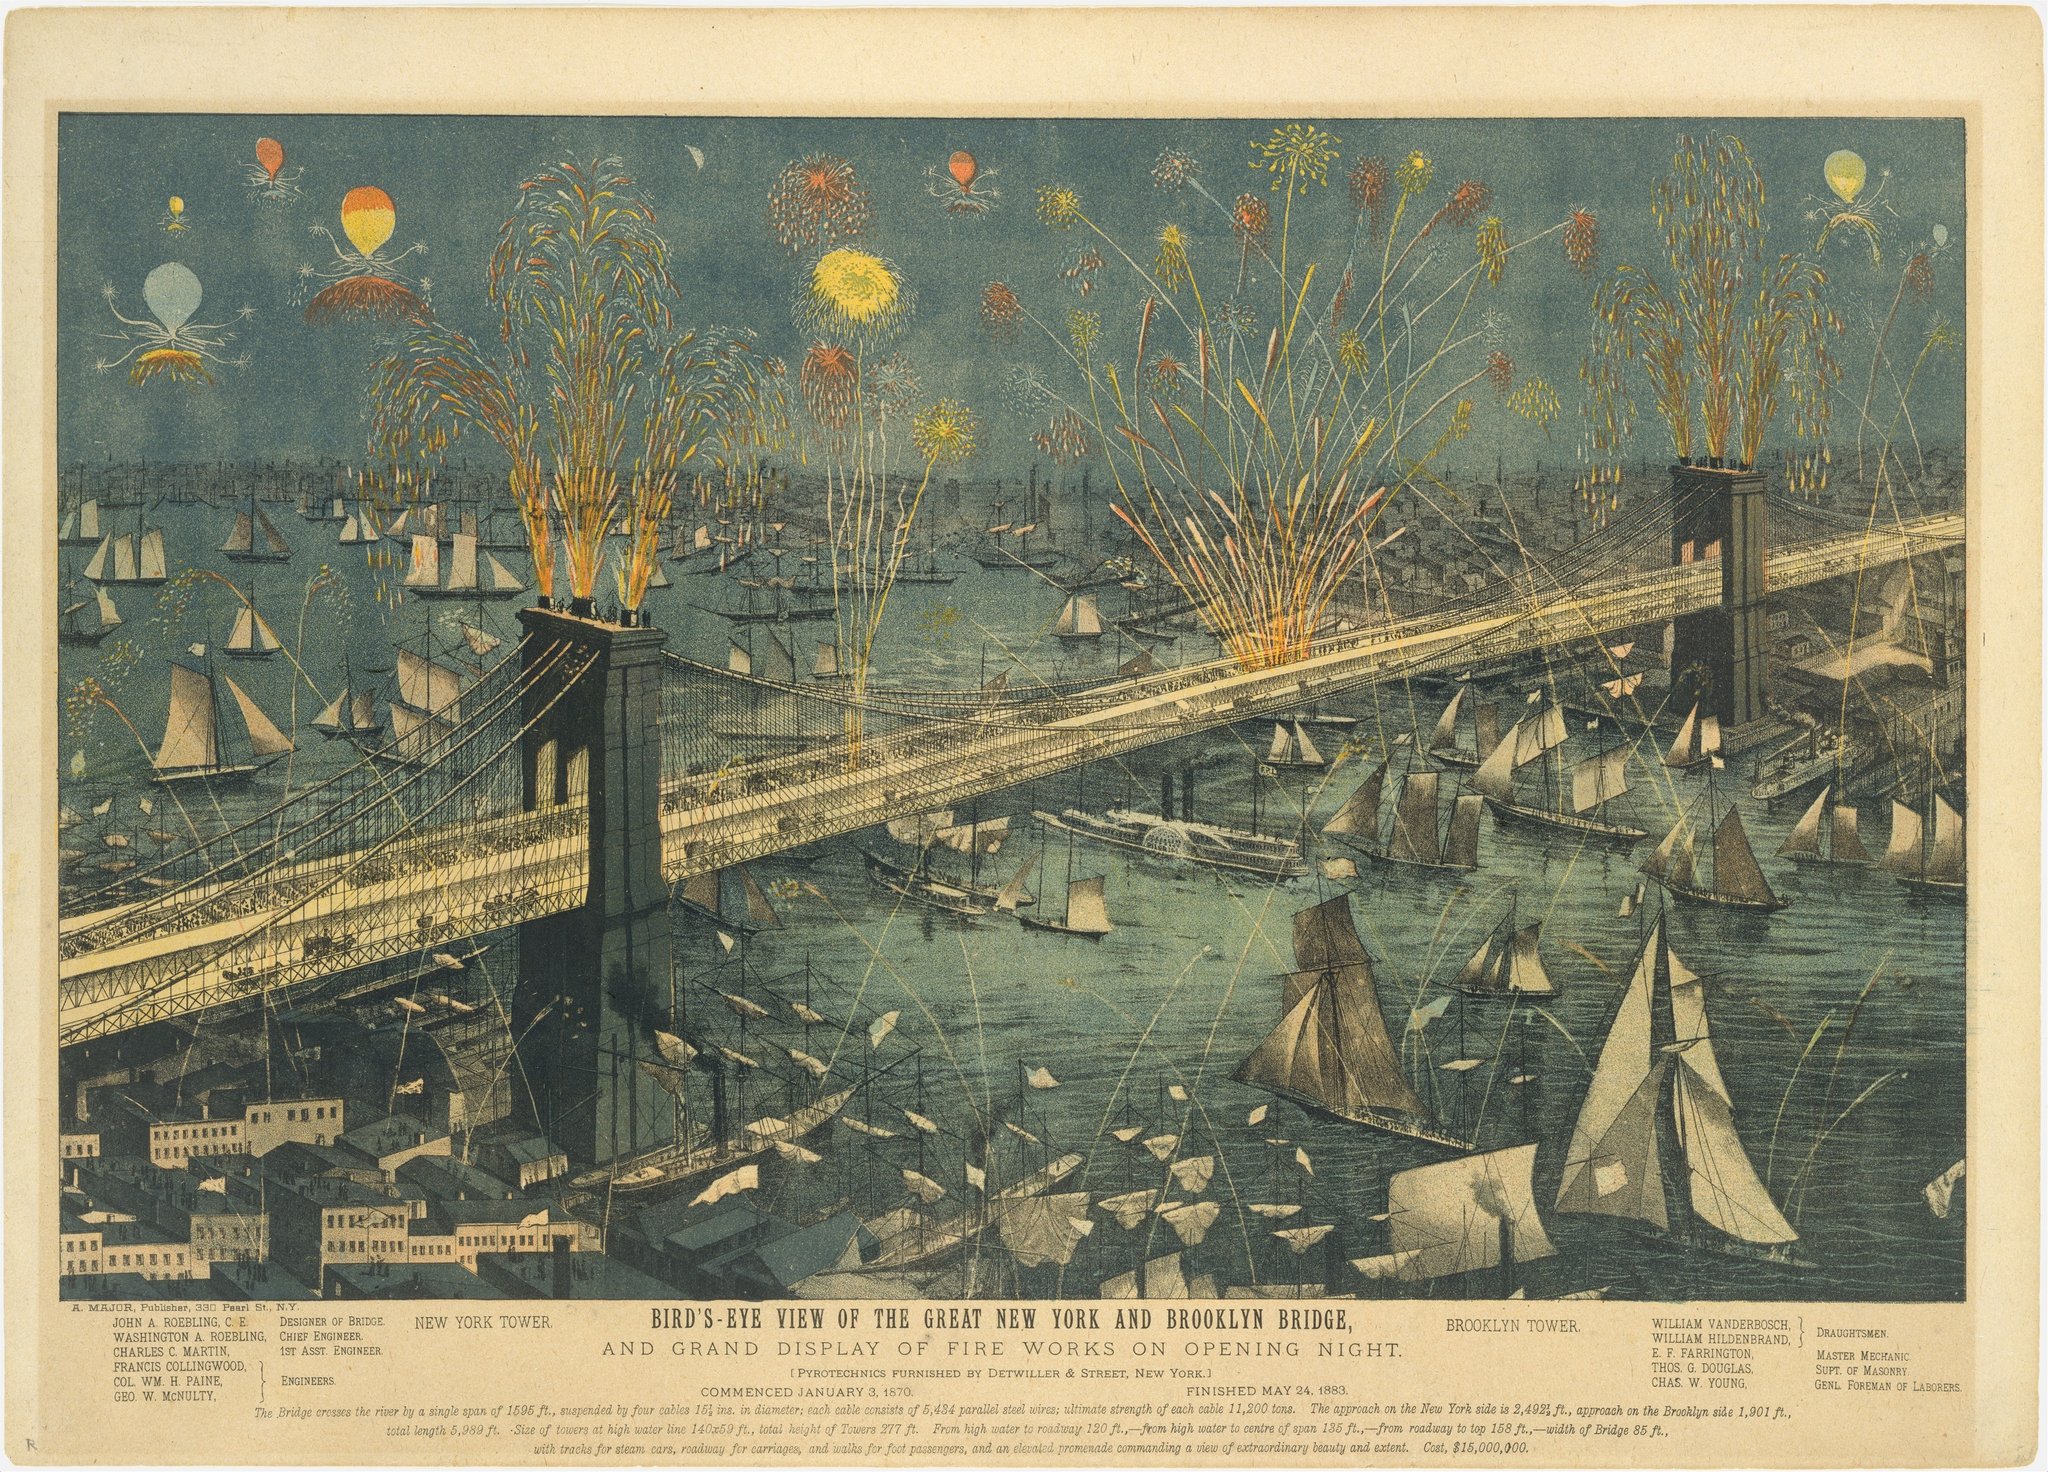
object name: print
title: Bird's-Eye View of the Great New York and Brooklyn Bridge, and Grand Display of Fireworks on Opening Night...May 24, 1883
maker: a. major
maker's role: publisher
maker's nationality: american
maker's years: 1800-1900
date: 1883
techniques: lithograph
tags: bridges,fireworks,night,boats,new york city